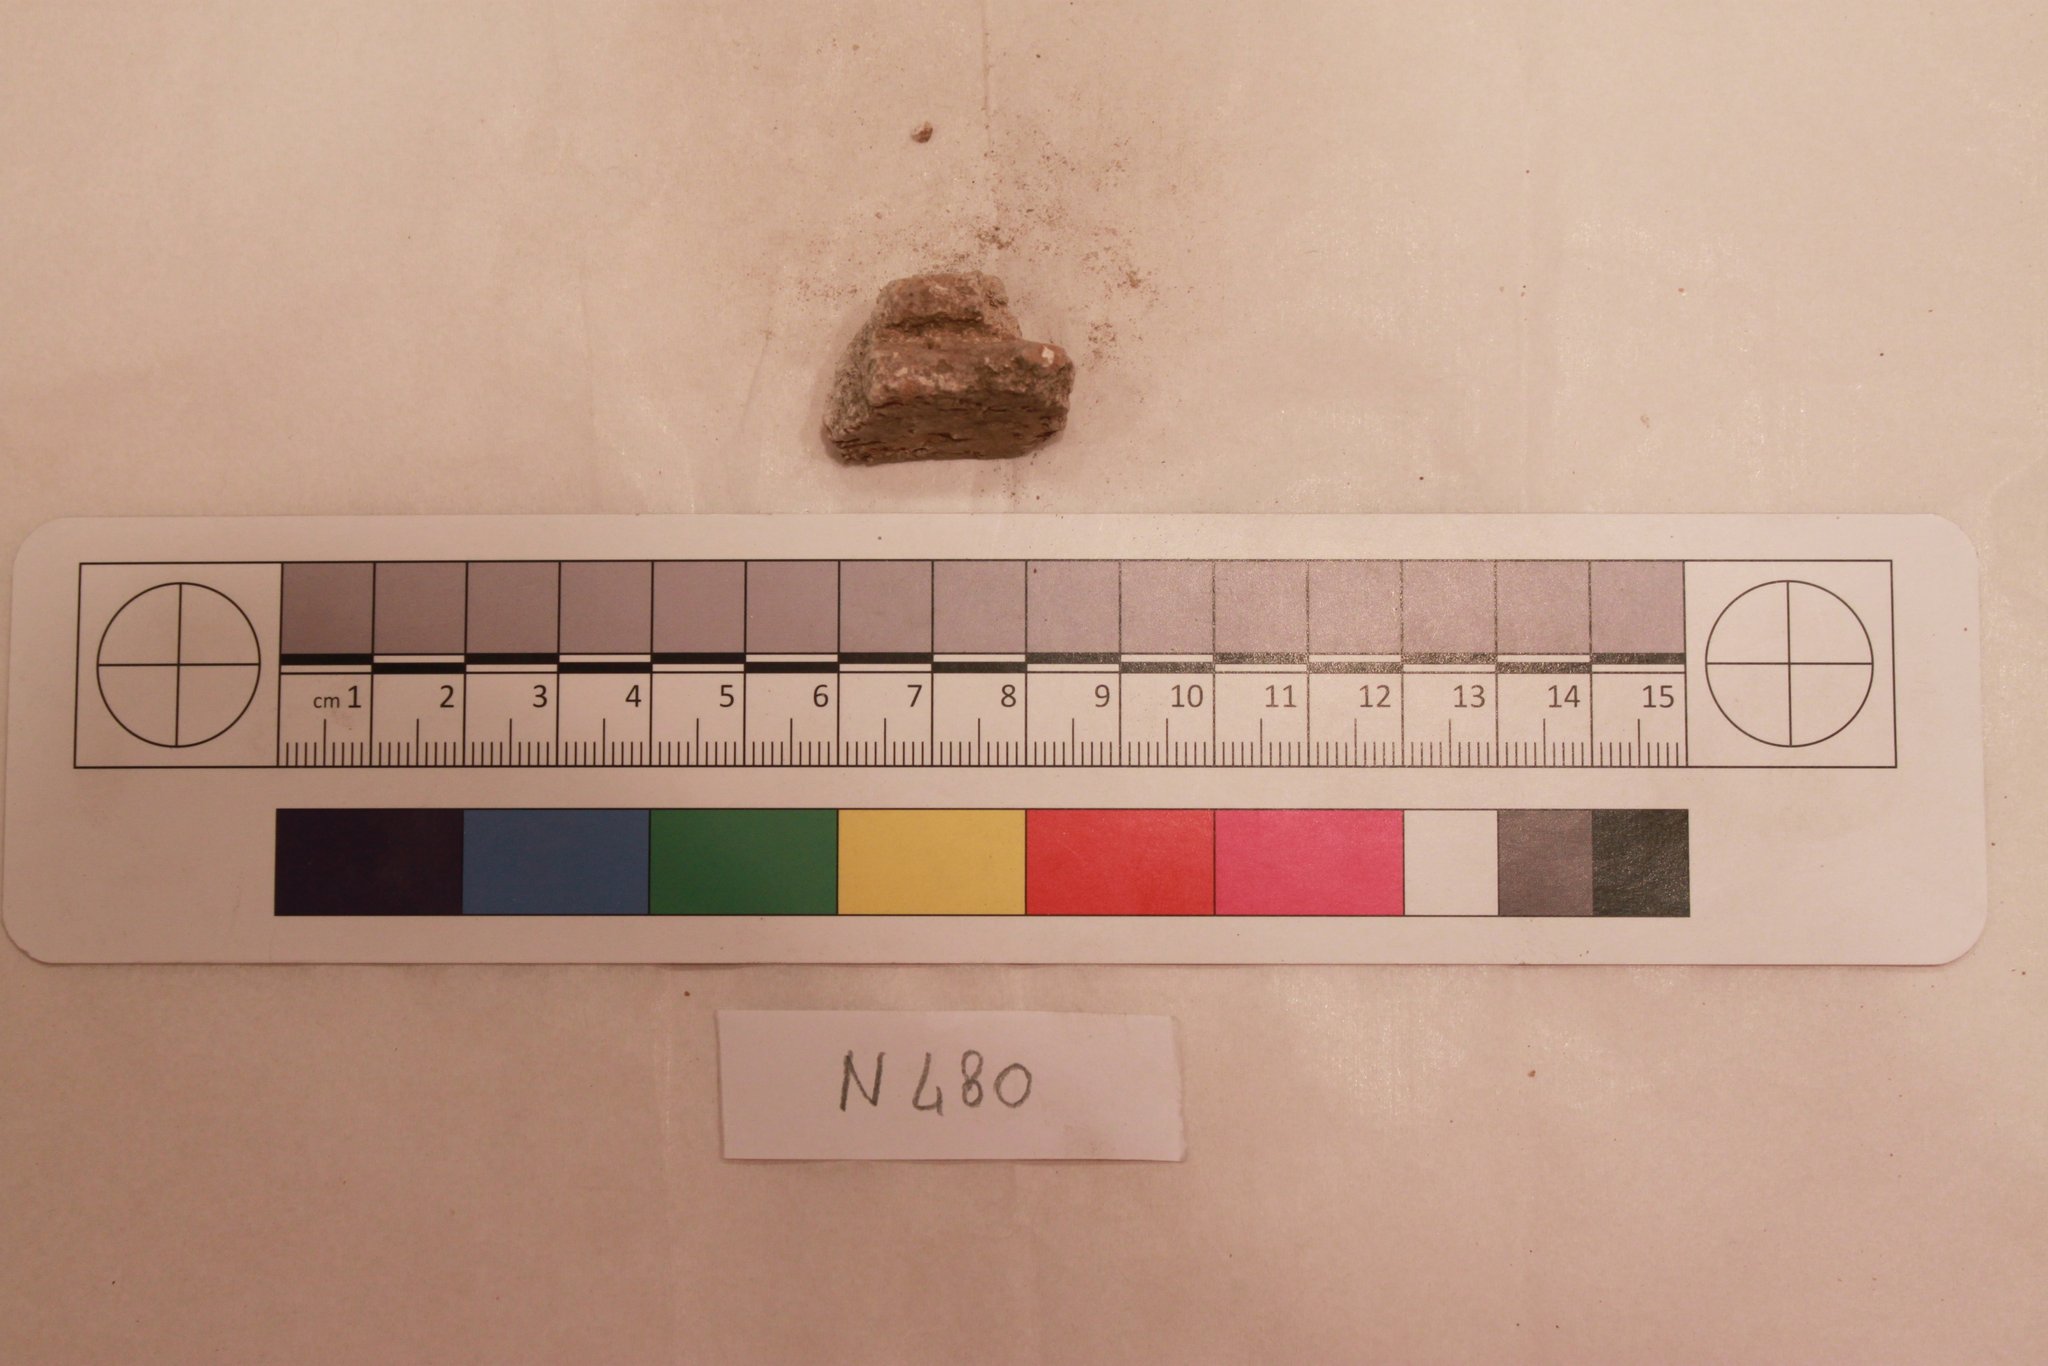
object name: fragment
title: Stucco Fragment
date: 701-1200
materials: plaster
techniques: carving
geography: iran